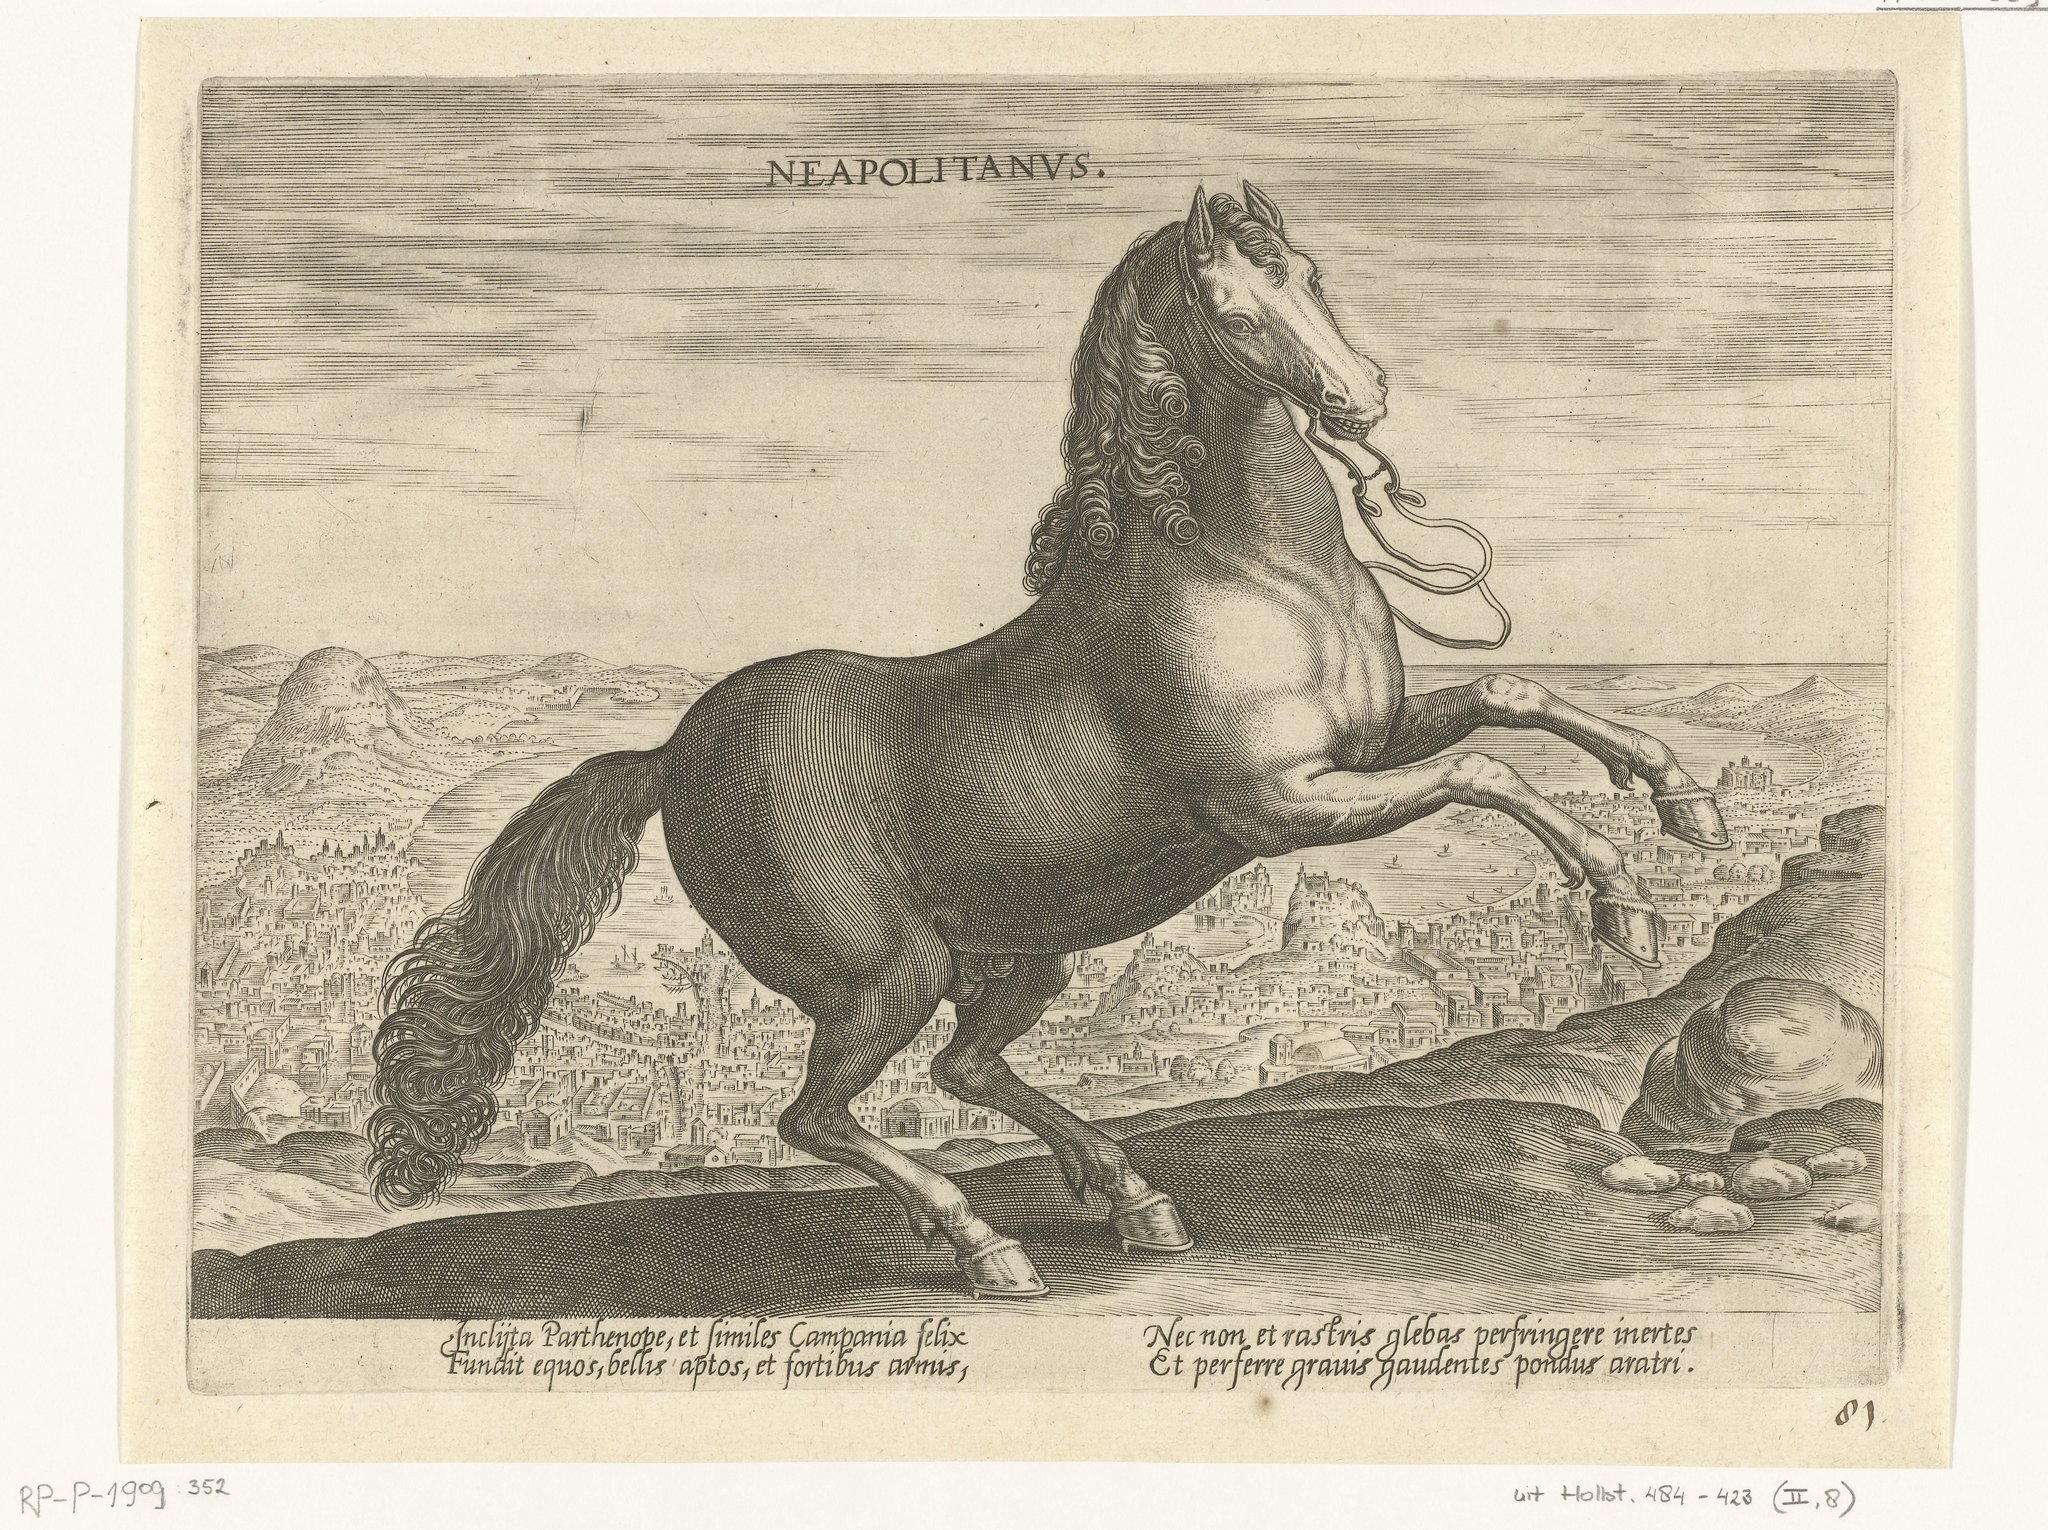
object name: print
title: Paard uit Napels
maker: philips galle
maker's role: print maker, publisher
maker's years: 1537-1612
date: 1578-1582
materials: paper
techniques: engraving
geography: florence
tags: don juan van oostenrijk, horses and kindred animals, naples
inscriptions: number: ‘81’, collector's mark: Lugt 2228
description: Een Napolitaner paard, in profiel. Het steigert. De prent heeft een Latijns onderschrift en maakt deel uit van het tweede deel van een 39-delige serie over de paardenrassen uit Koninklijke stallen van Don Juan van Oostenrijk.